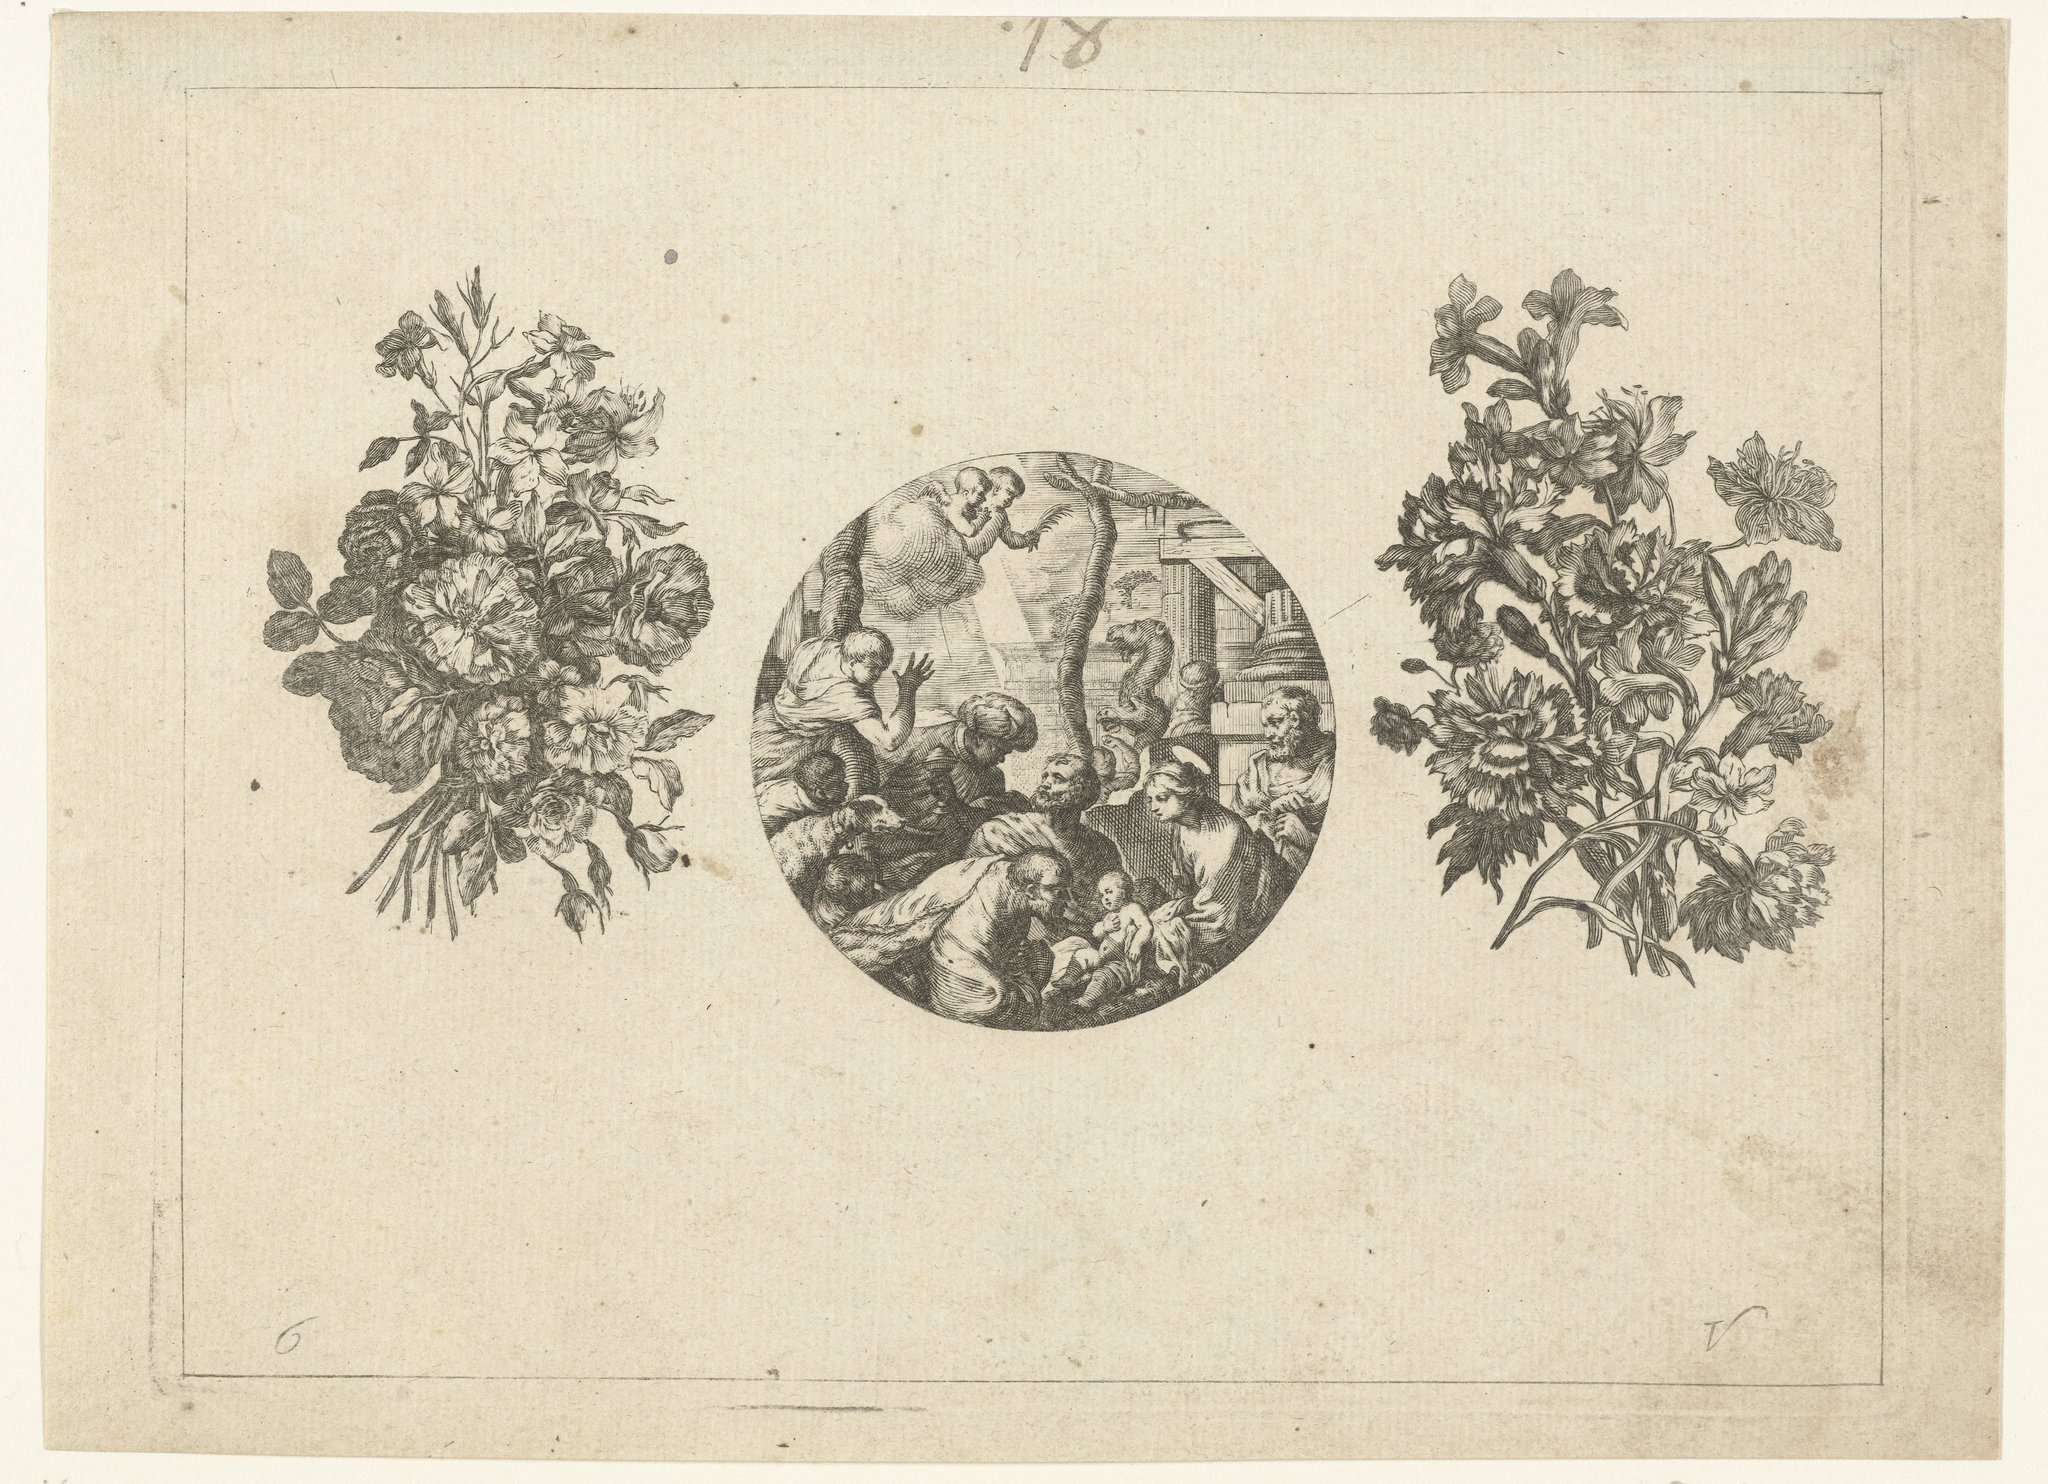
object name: ornament print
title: Edelsmidsontwerpen voor horlogekasten: deksels en zijkanten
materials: paper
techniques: engraving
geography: france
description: Horlogekast met de Aanbidding der Herders. Eerste editie, tweede druk.